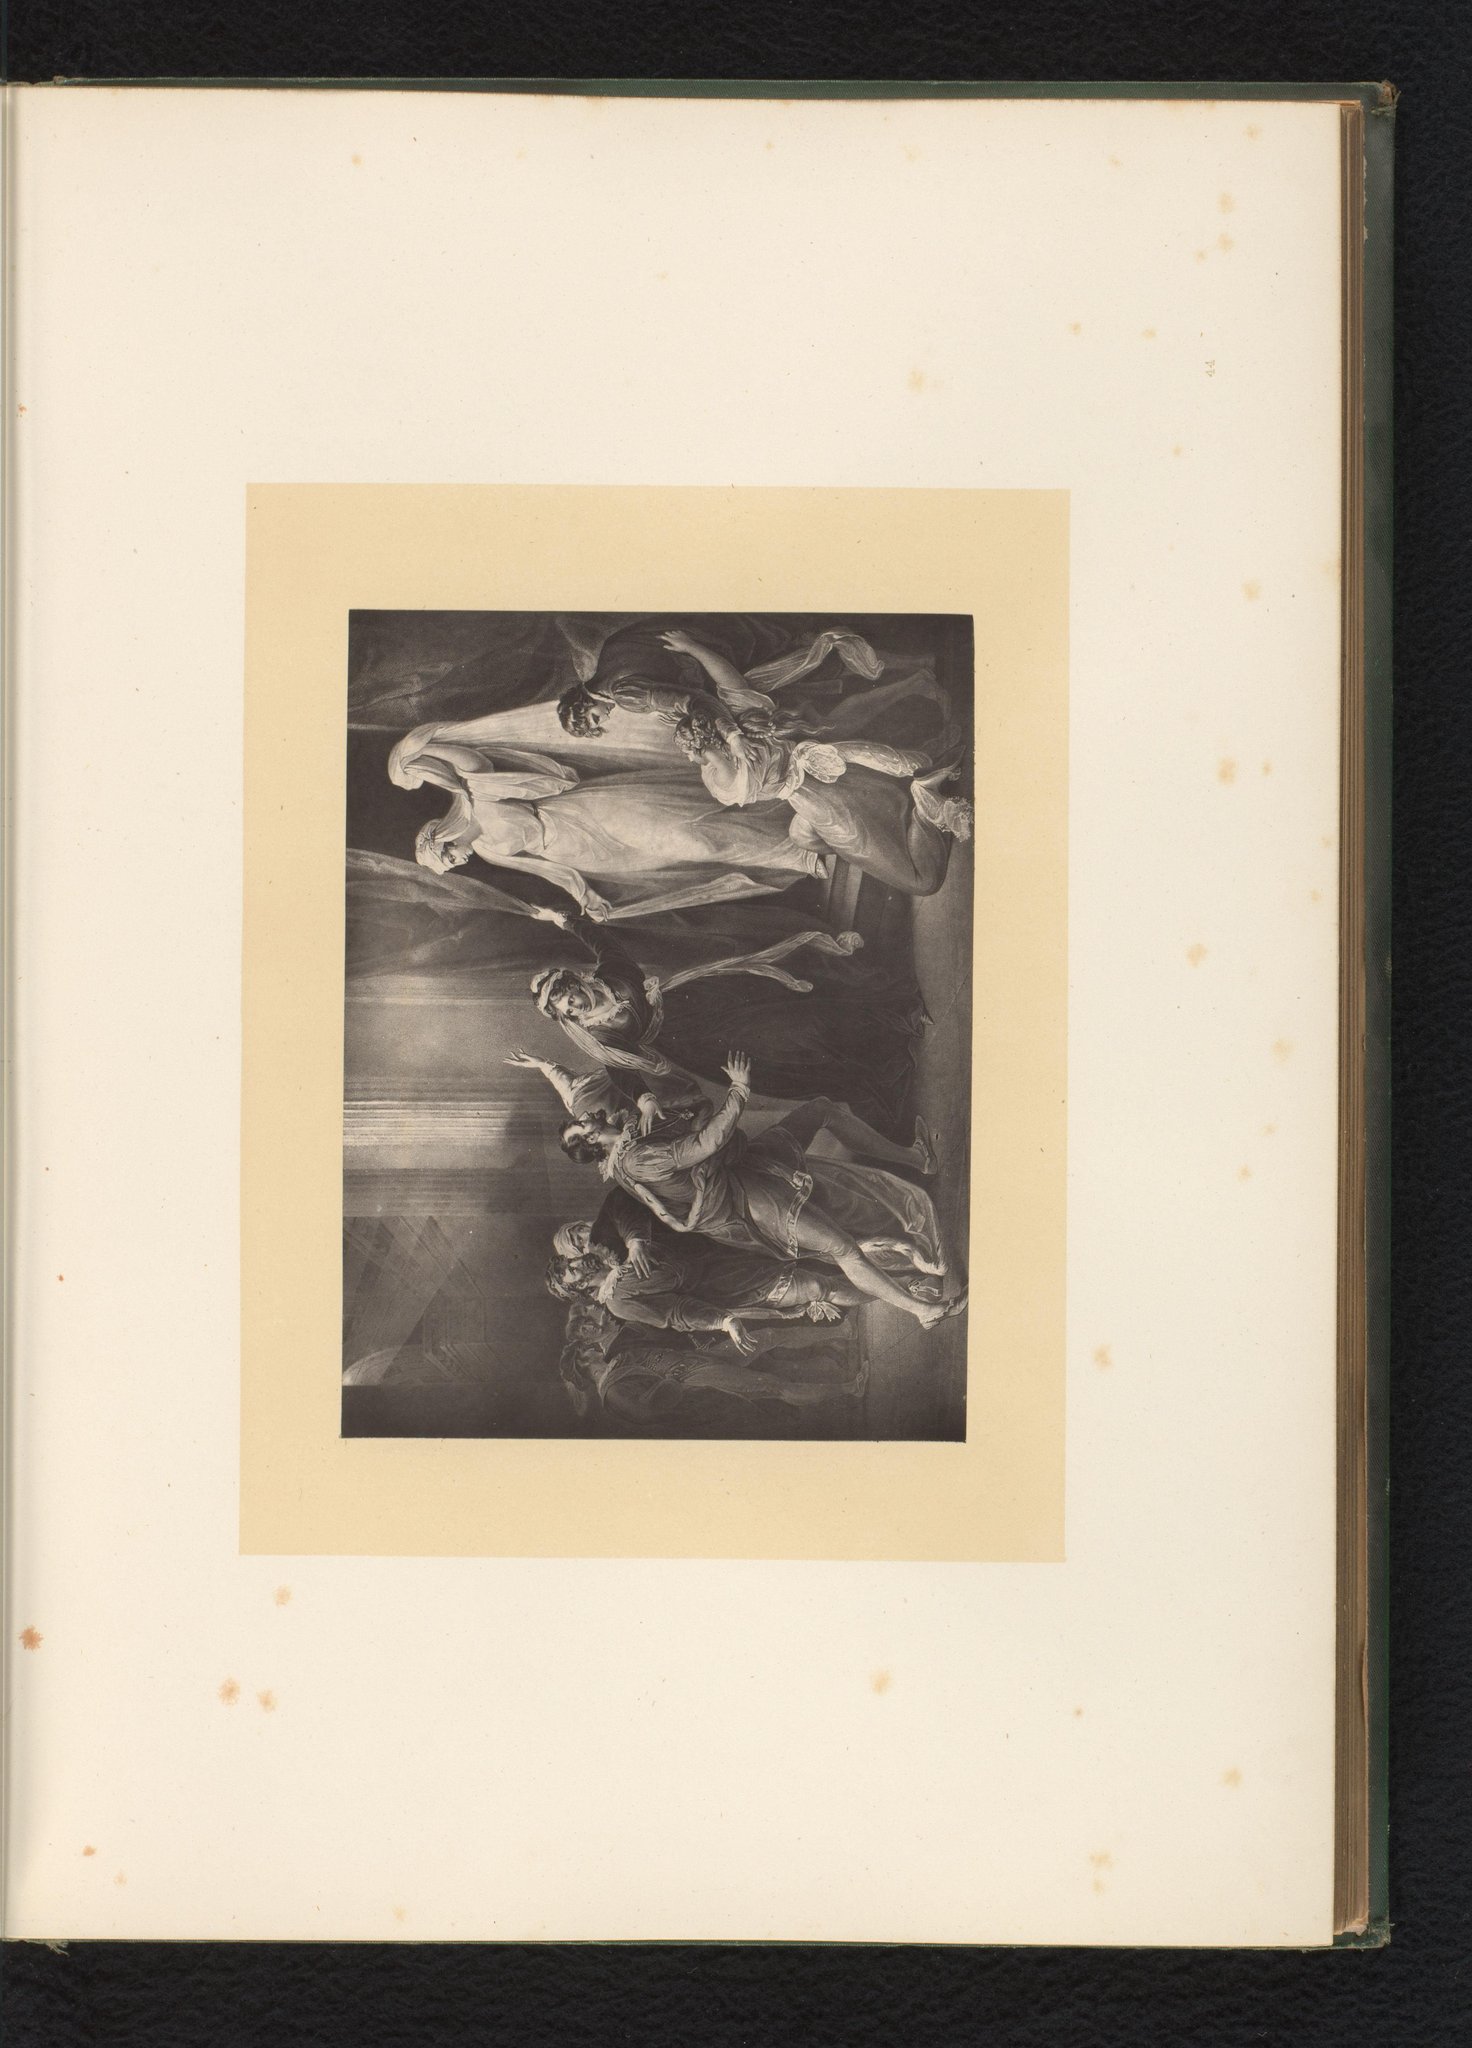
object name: page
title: The Winter's Tale, Act V, Scene 3: Paulina's House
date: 1874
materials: paper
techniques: woodburytype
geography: london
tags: comedy